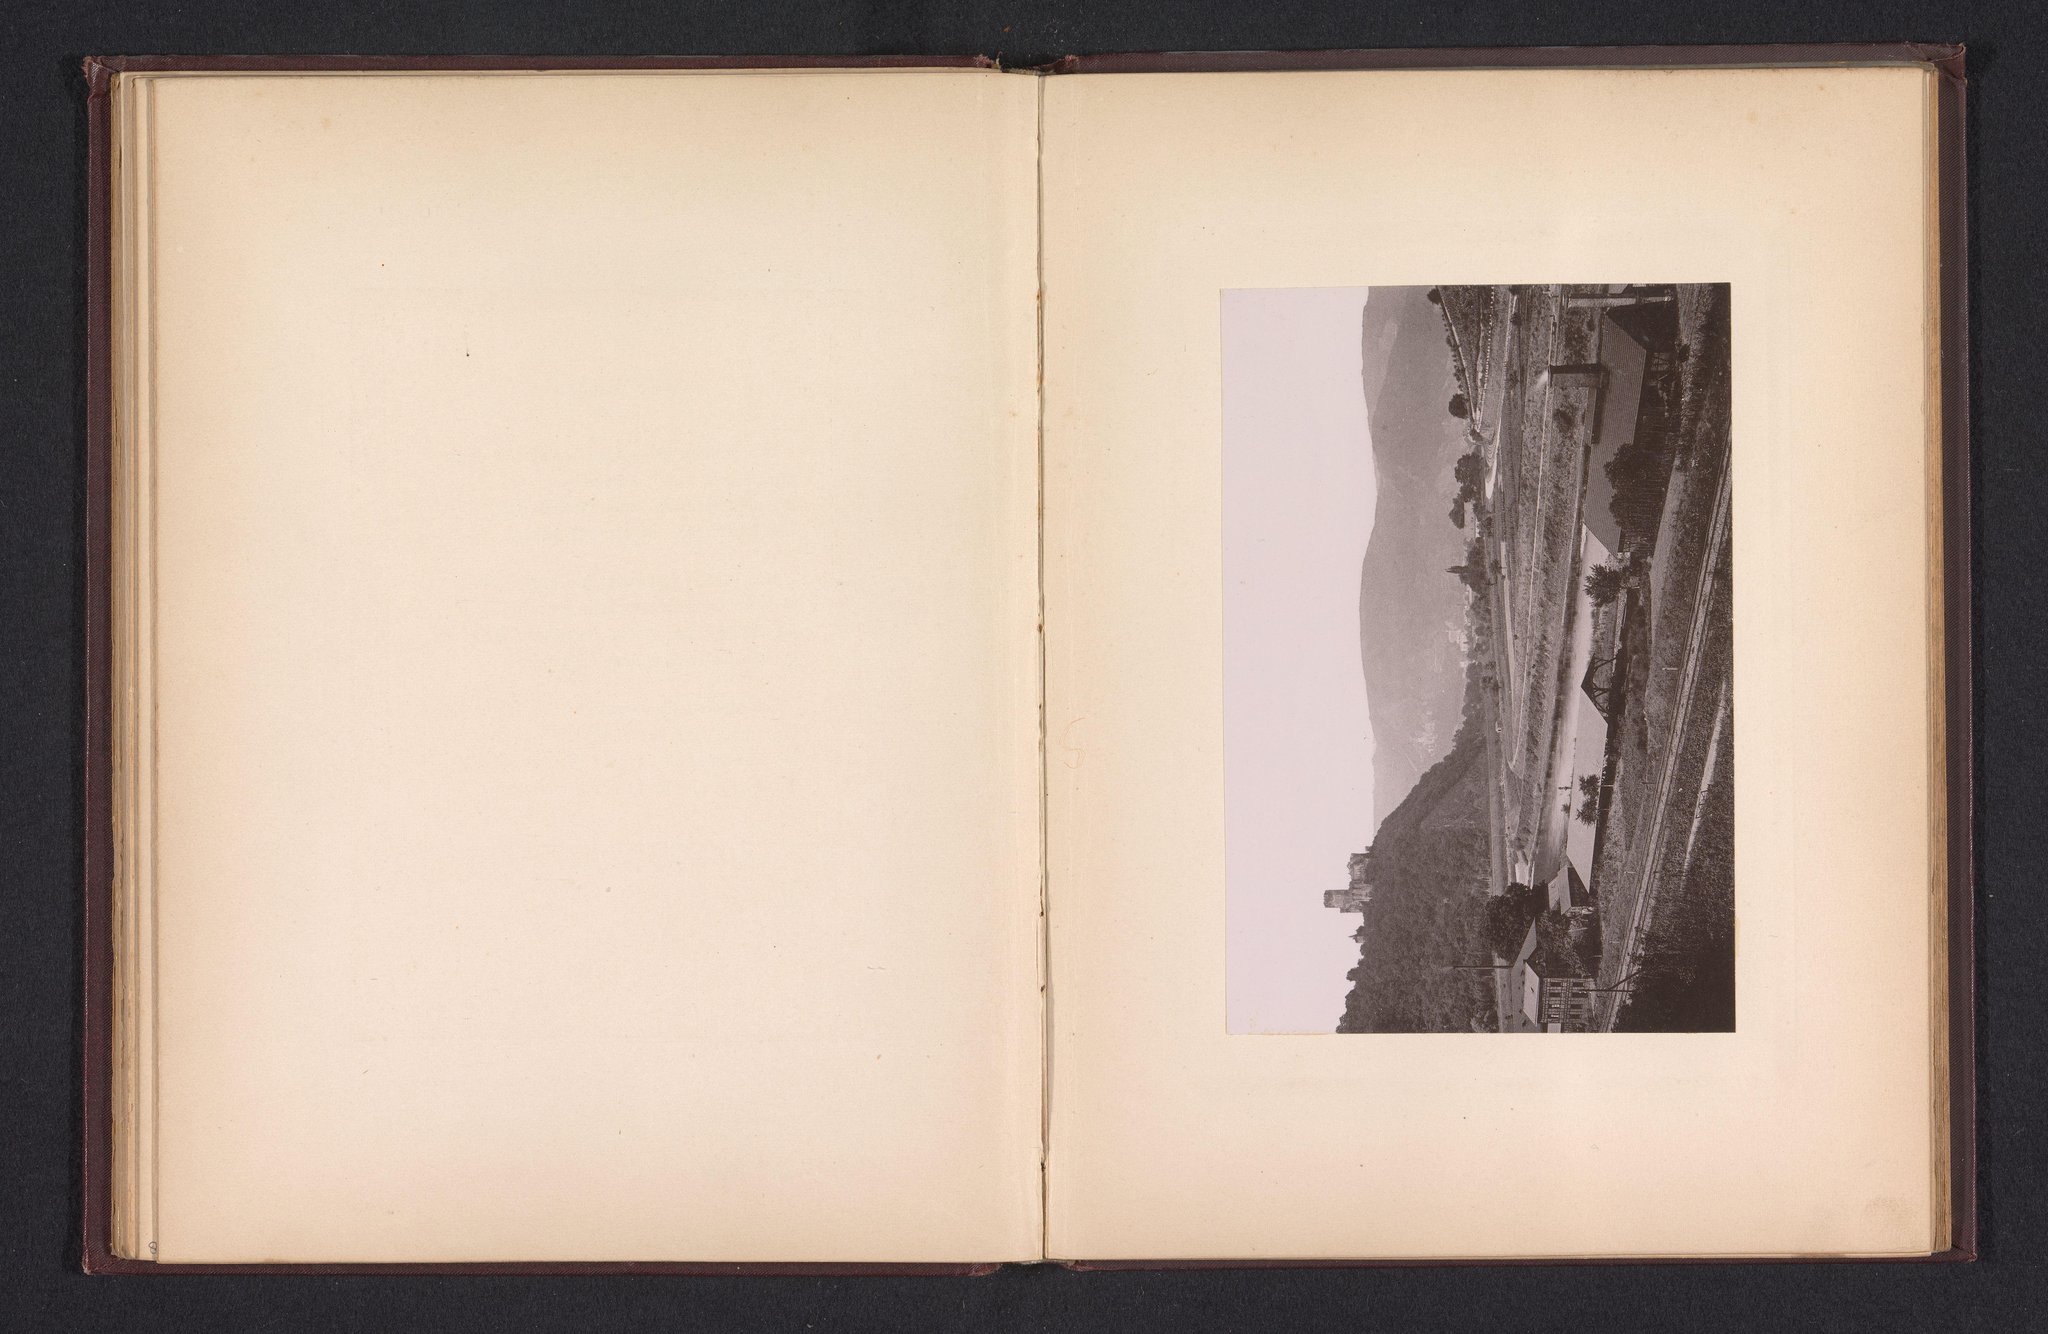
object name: page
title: Gezicht op de Burg Lahneck aan de Rijn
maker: Anonymous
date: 1881-1891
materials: paper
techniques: photograph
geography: dresden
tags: castle, river